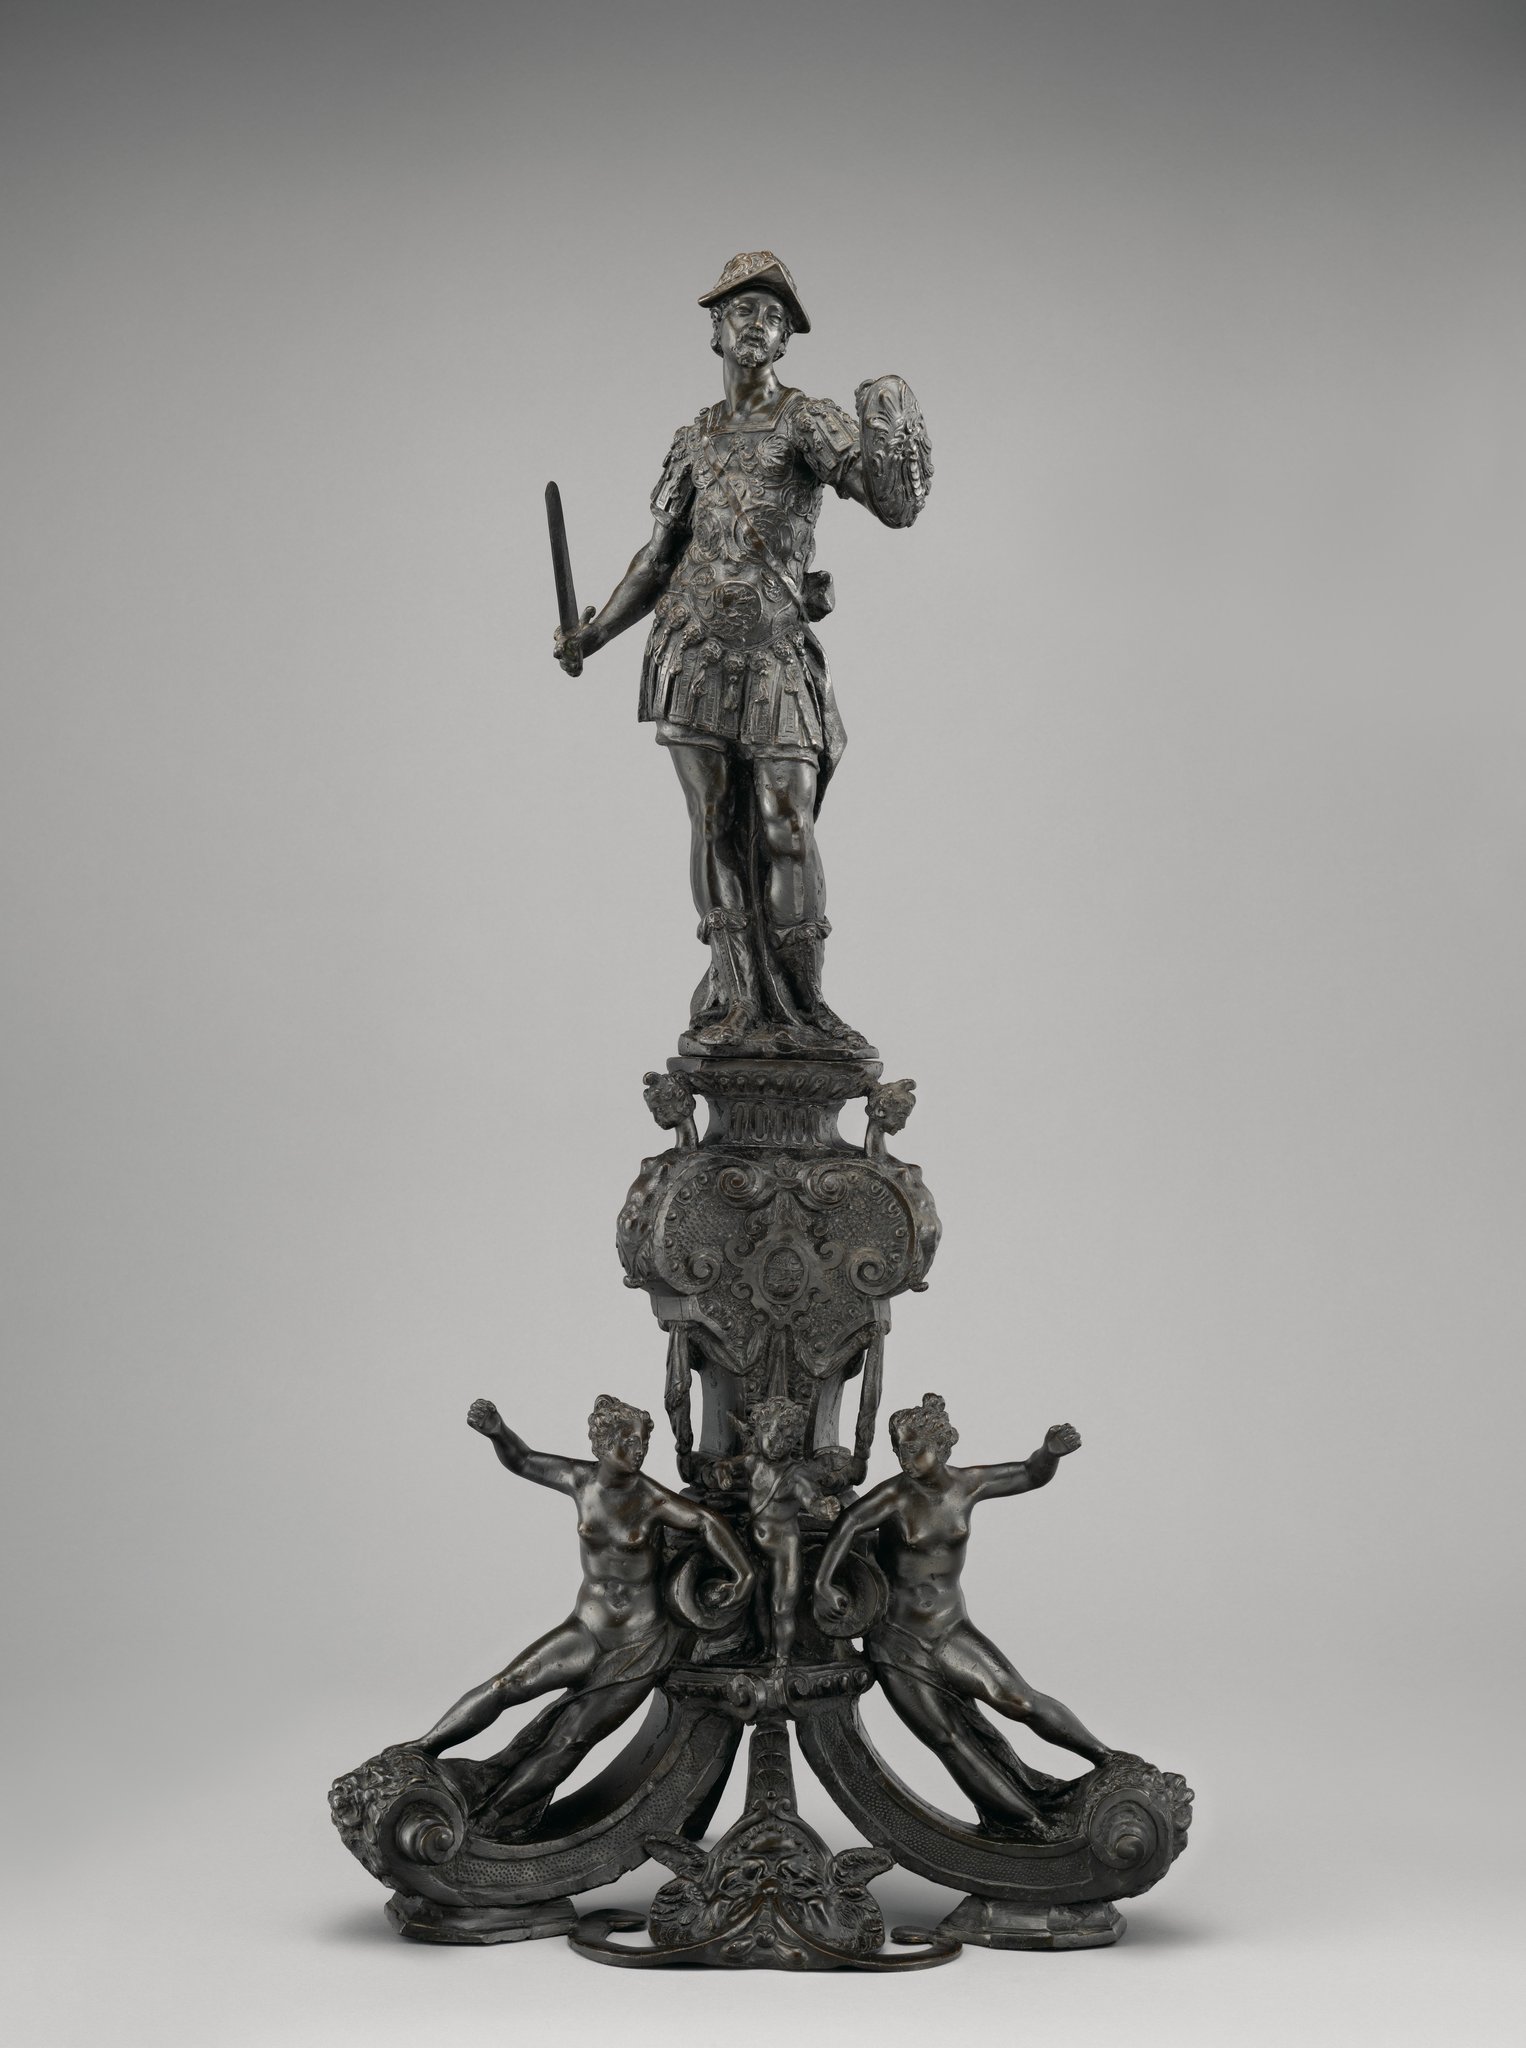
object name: andiron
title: Andiron with figure of Mars (one of a pair)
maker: danese cattaneo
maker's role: artist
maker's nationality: italian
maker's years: 1512-1572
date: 1601-1633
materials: bronze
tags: female nudes,cupid,mars